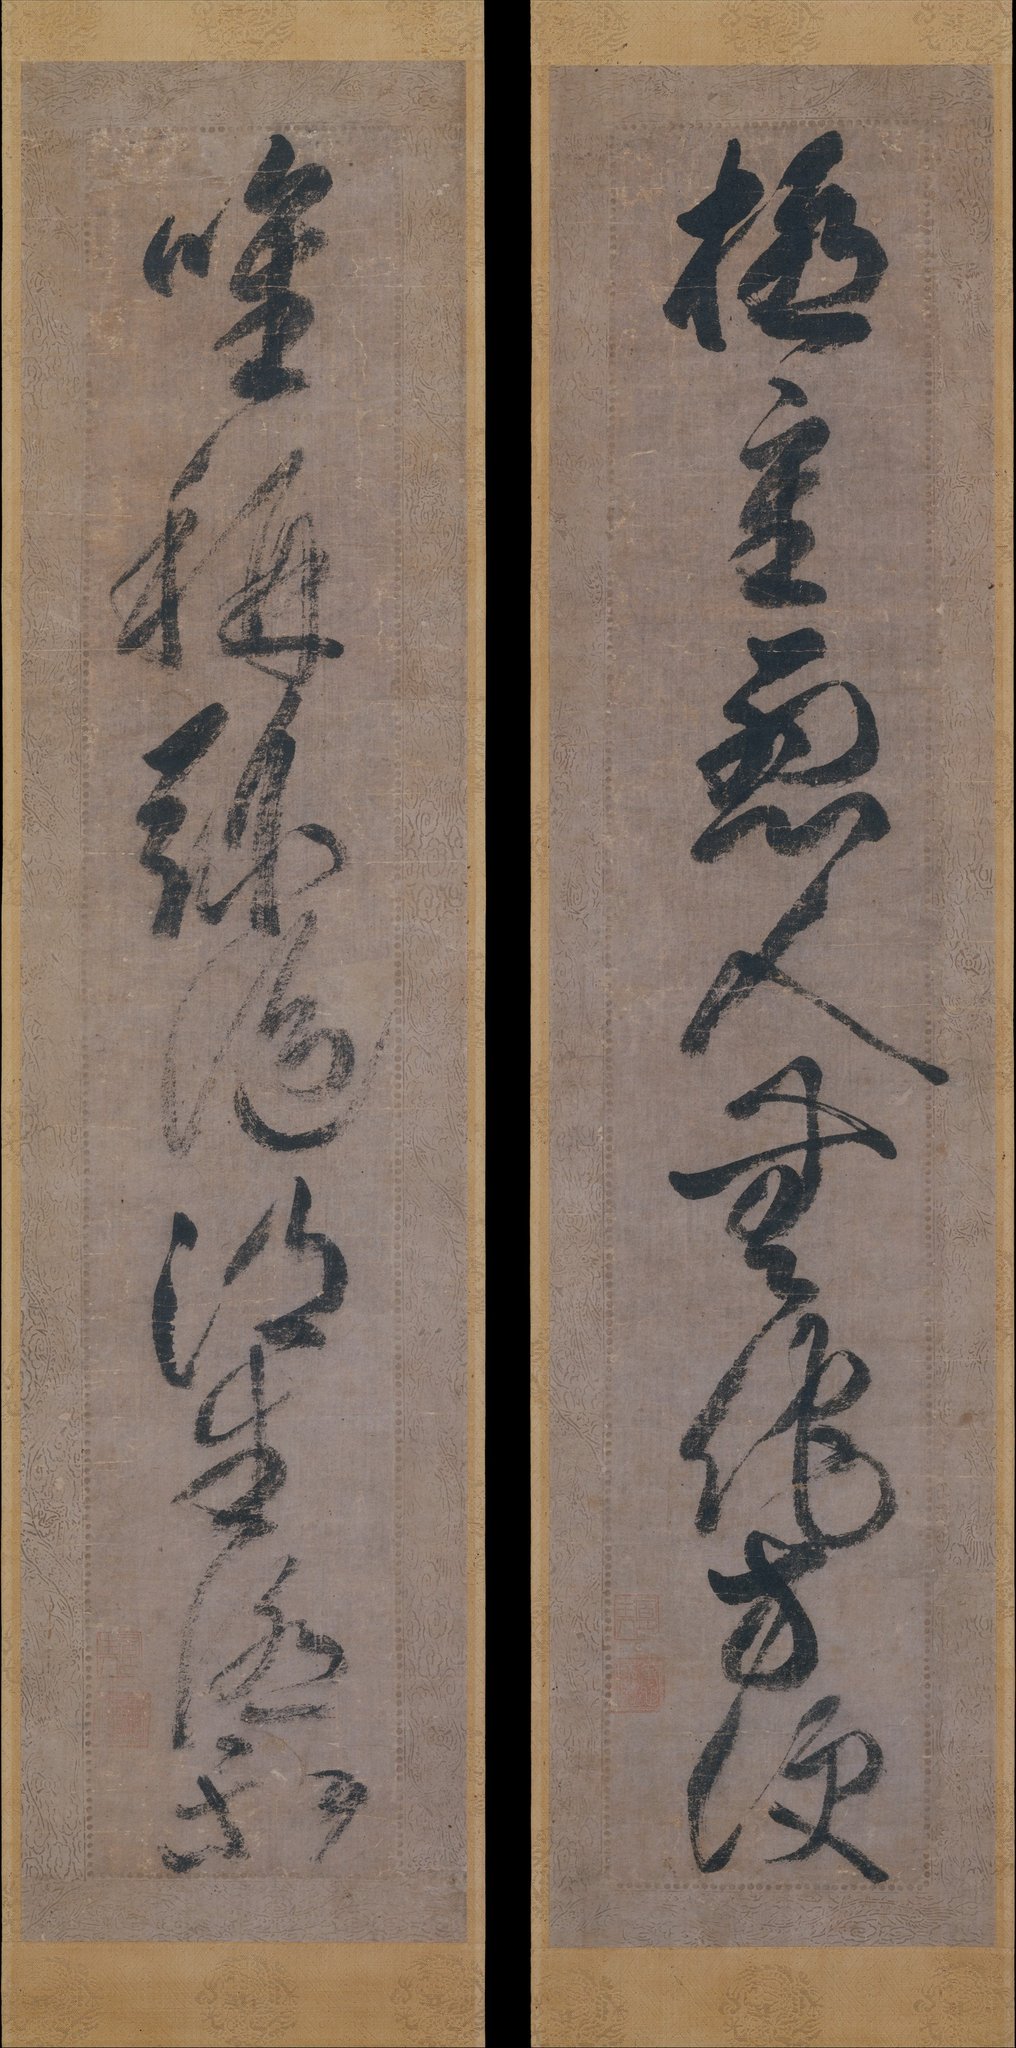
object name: hanging scroll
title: Buddhist Maxim on the Saving Power of Amida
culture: japanese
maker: gukyoku reisai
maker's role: artist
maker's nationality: japanese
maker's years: 1369-1452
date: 1401-1450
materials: ink, paper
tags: buddhism,calligraphy